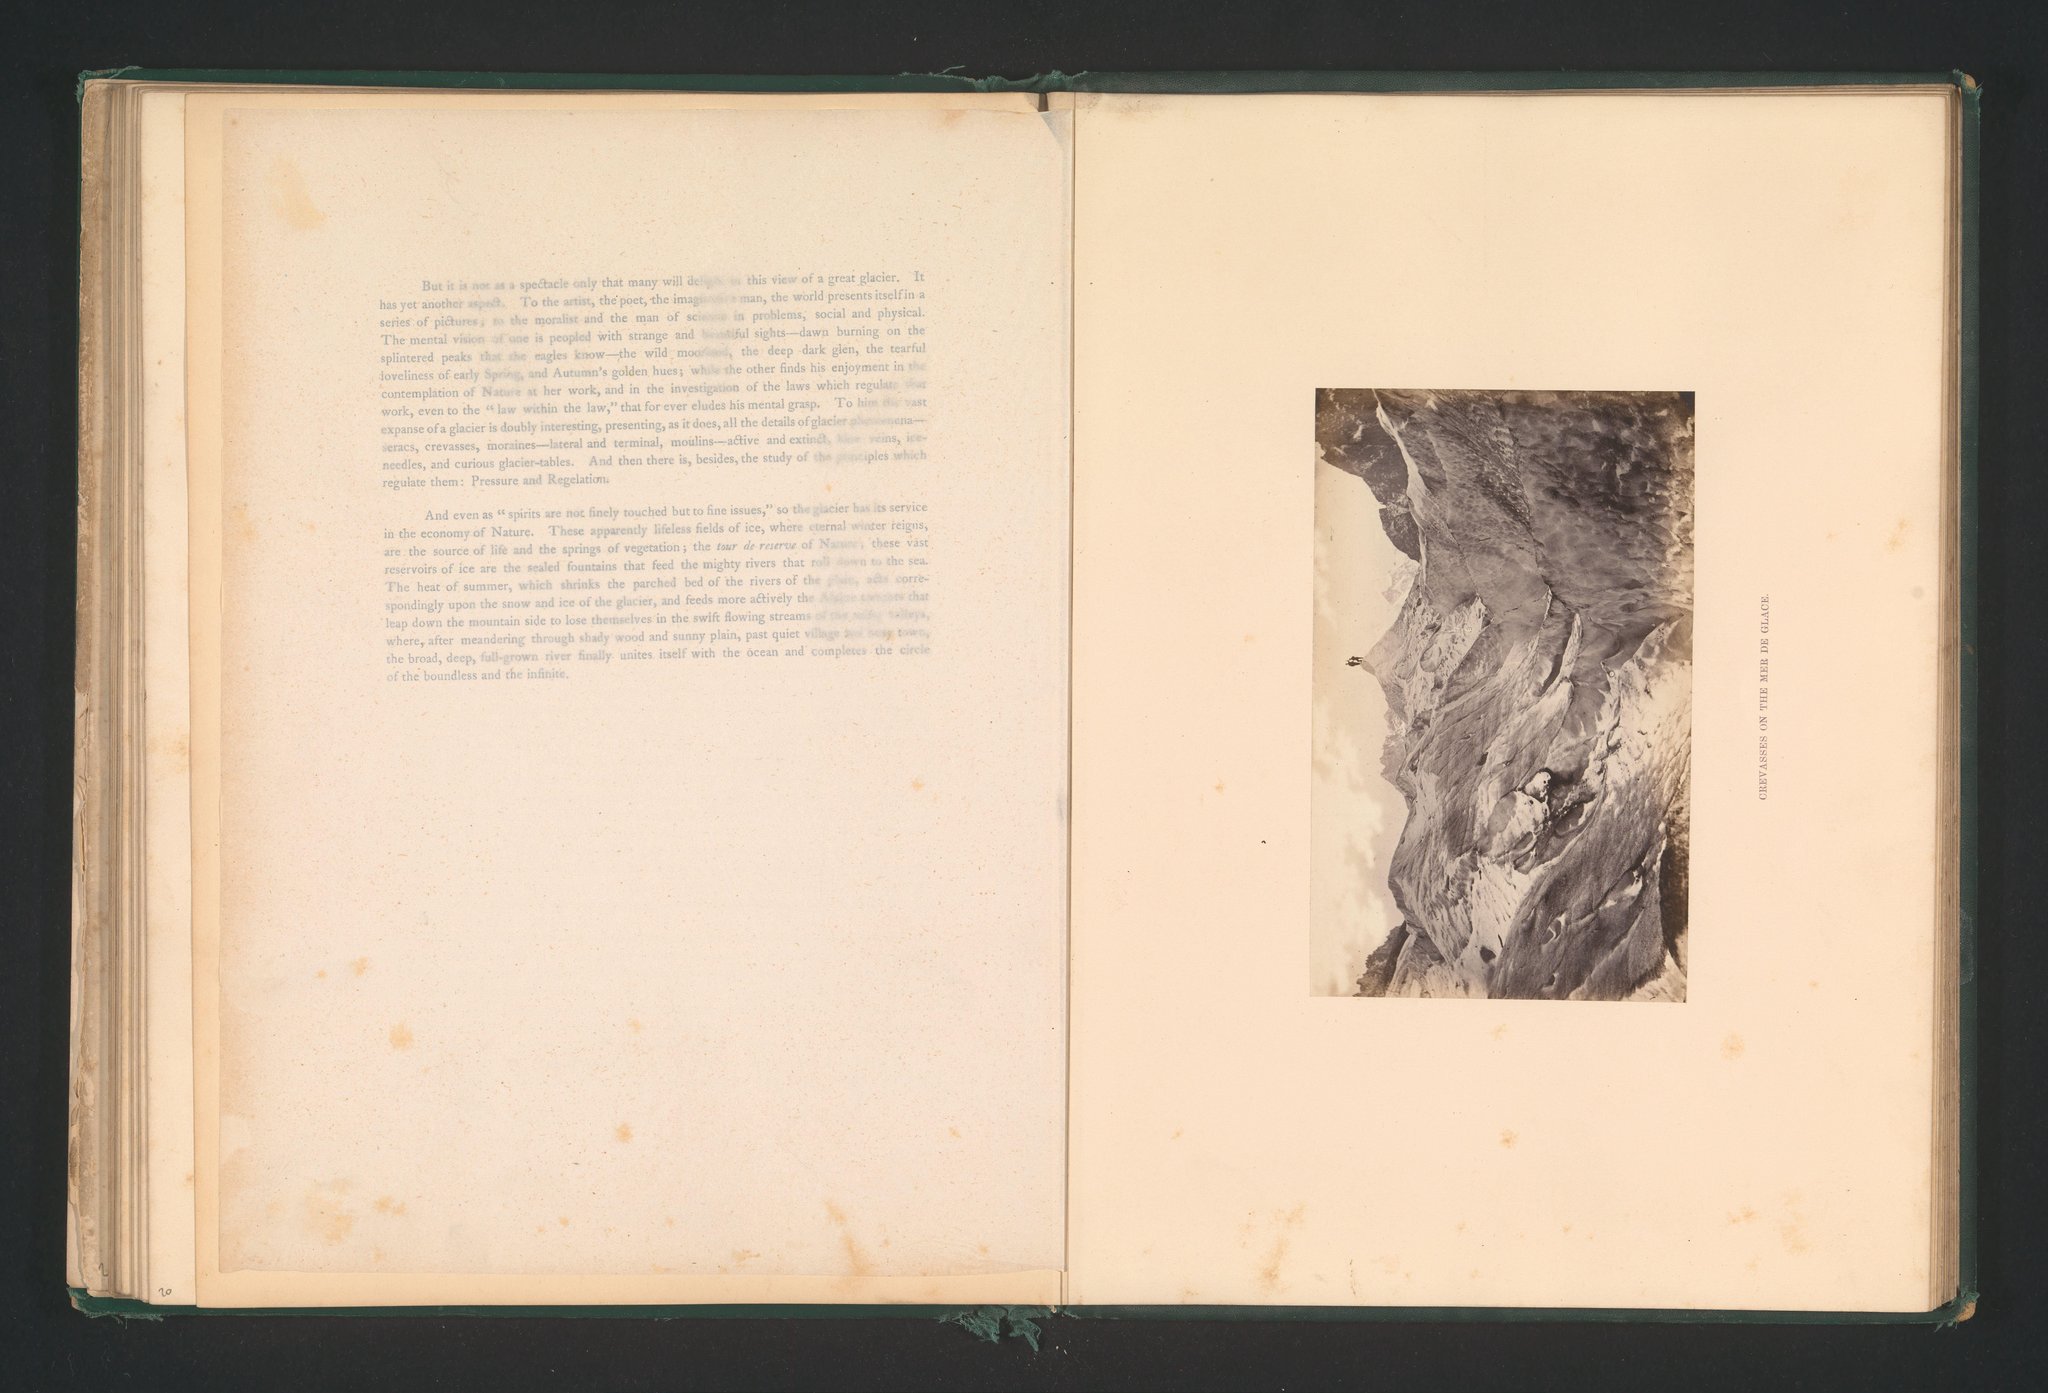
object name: page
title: Gletsjerspleten van de Mer-de-Glace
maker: stephen thompson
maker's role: fotograaf, schrijver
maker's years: 1831-1893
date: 1863-1868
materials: photographic support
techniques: albumen print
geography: mer de glace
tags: glacier (+ landscape with figures, staffage)